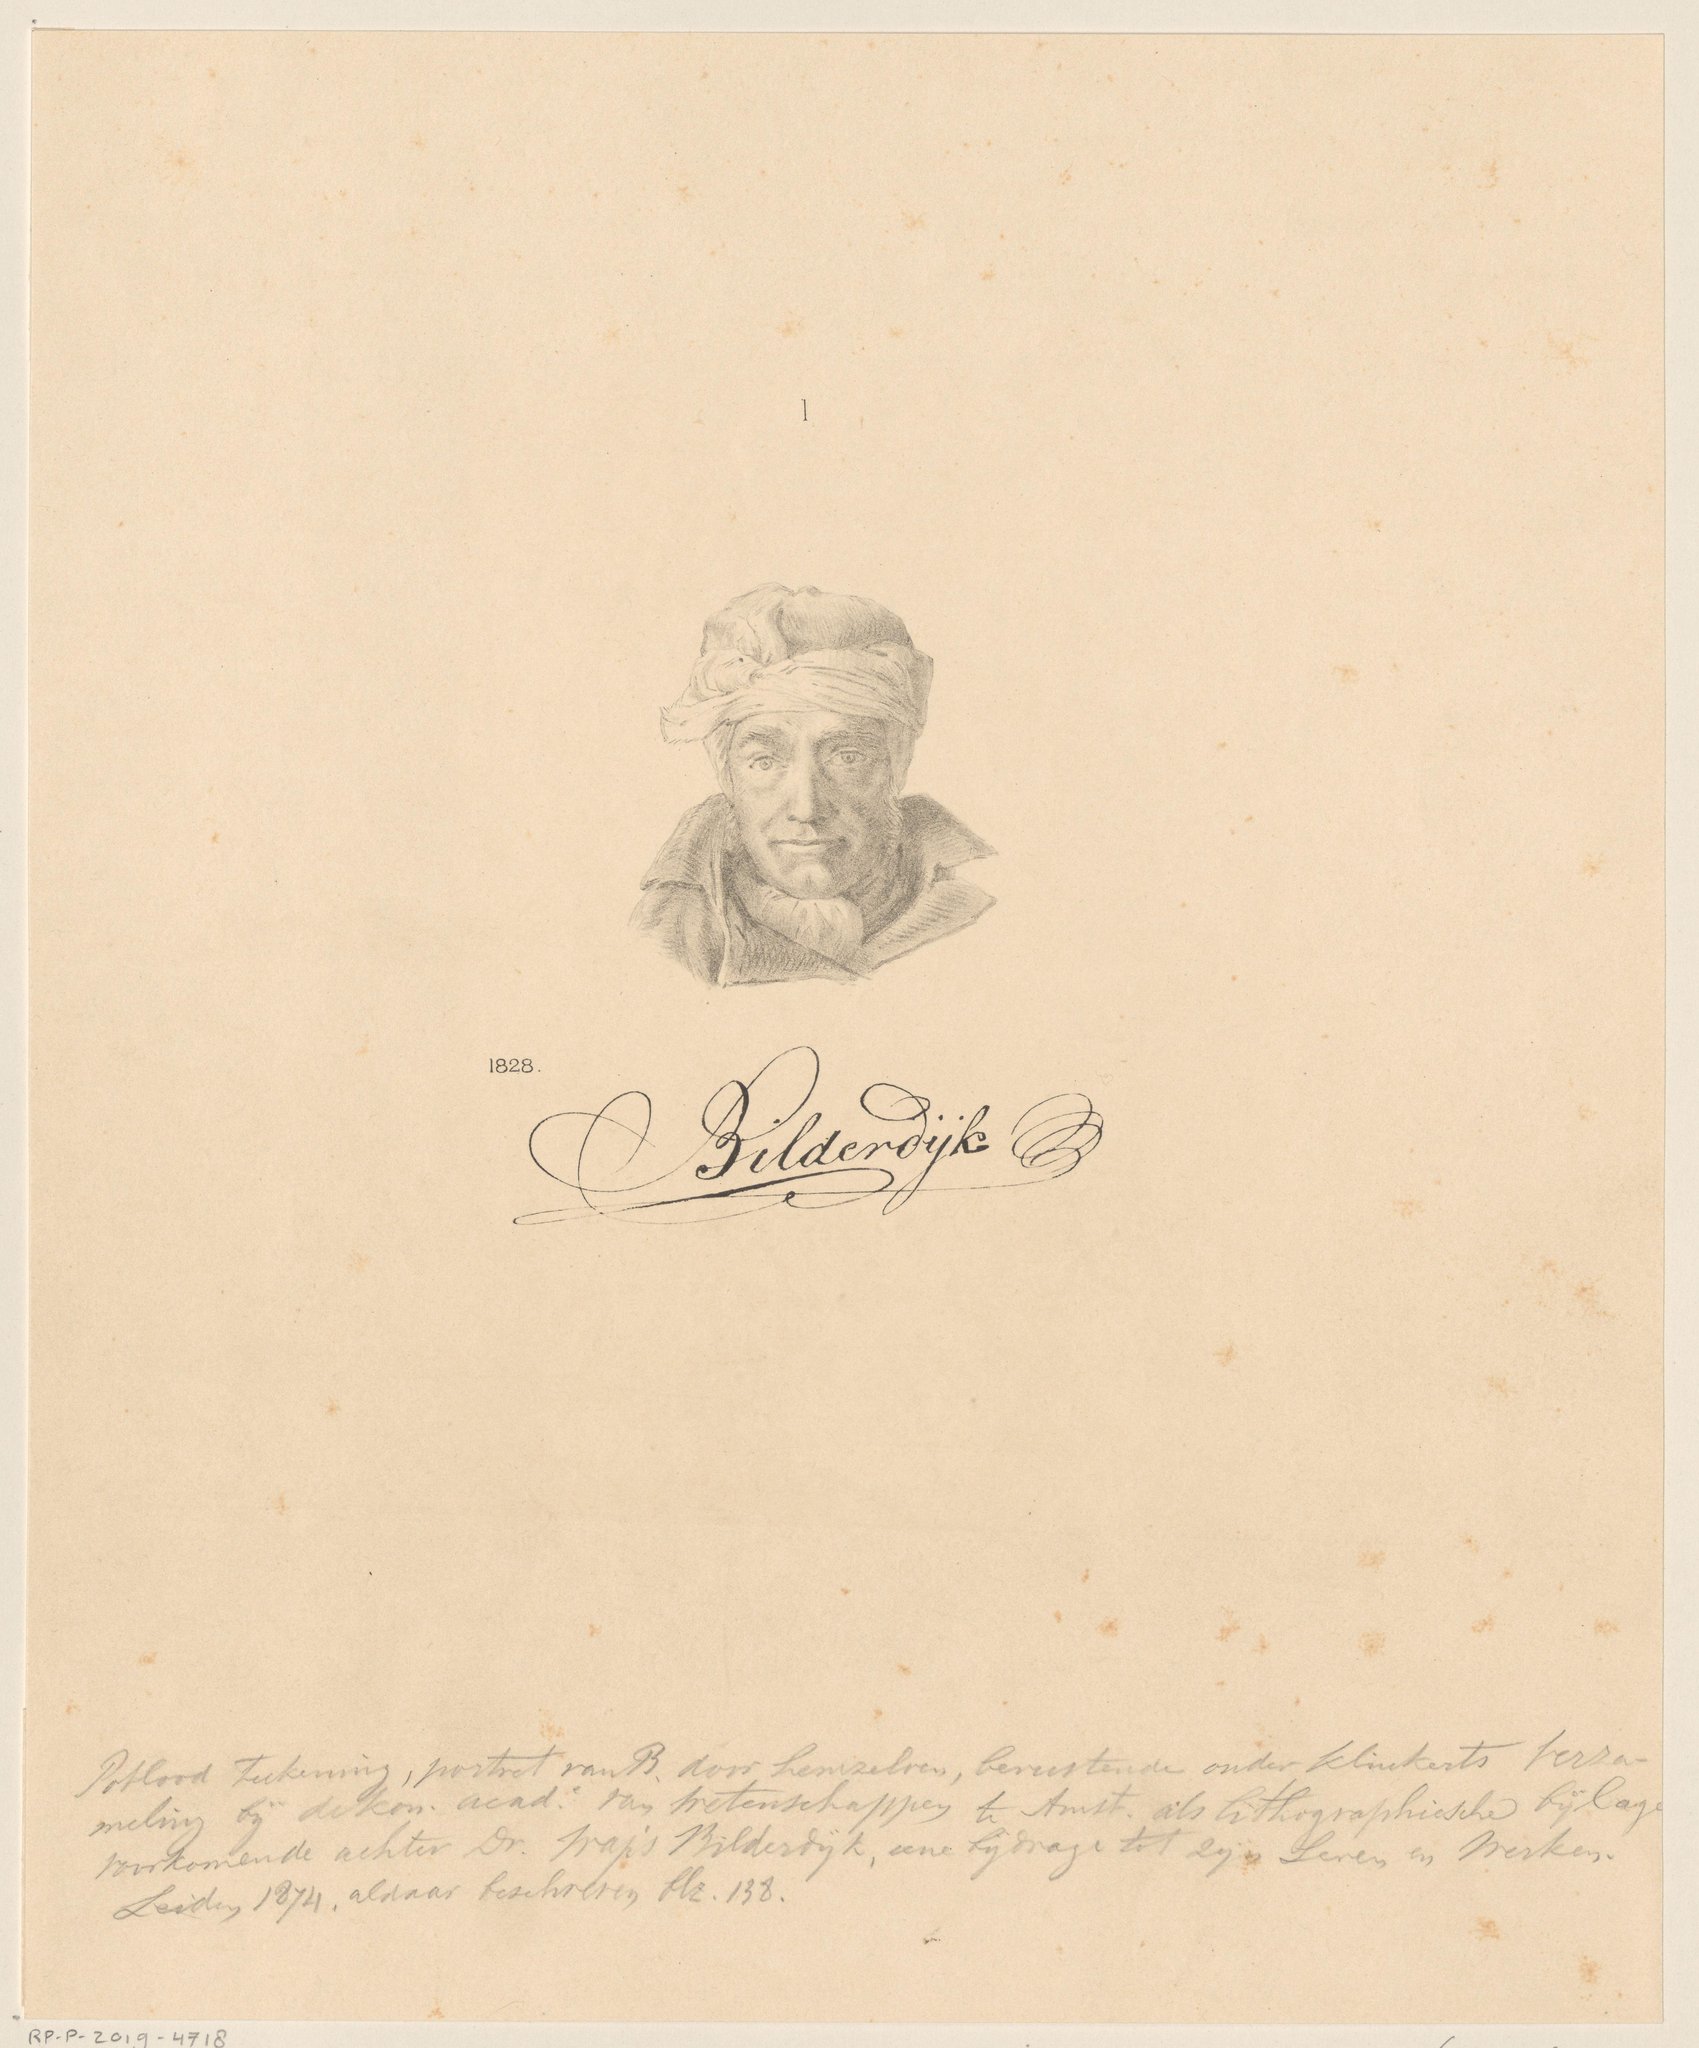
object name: book illustration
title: Portret van Willem Bilderdijk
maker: Anonymous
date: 1874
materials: paper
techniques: lithograph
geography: leiden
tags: amsterdam, haarlem, print maker, draughtsman, willem bilderdijk, historical persons, portrait of a writer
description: Prent uit: Wap, Jan. J.F. Bilderdijk: eene bijdrage tot zijn leven en werken. Leiden: E.J. Brill, 1874.